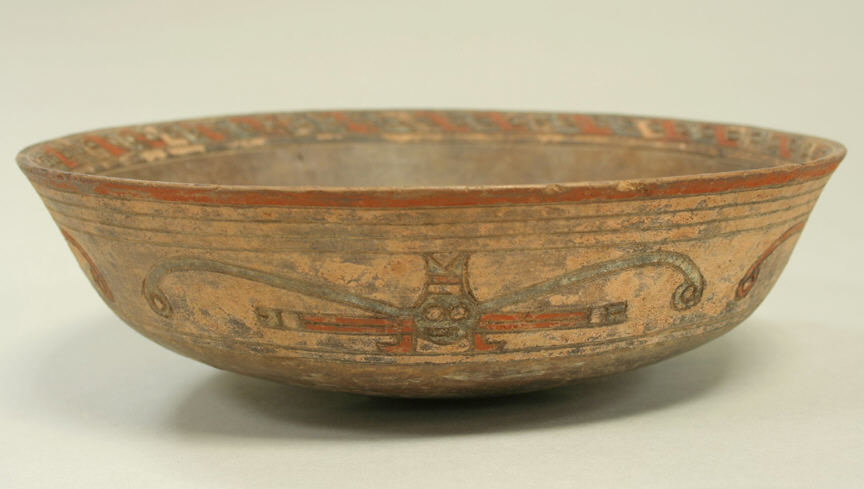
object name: bowl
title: Incised Painted Bowl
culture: paracas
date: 500-101 BCE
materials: ceramic, pigment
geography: peru